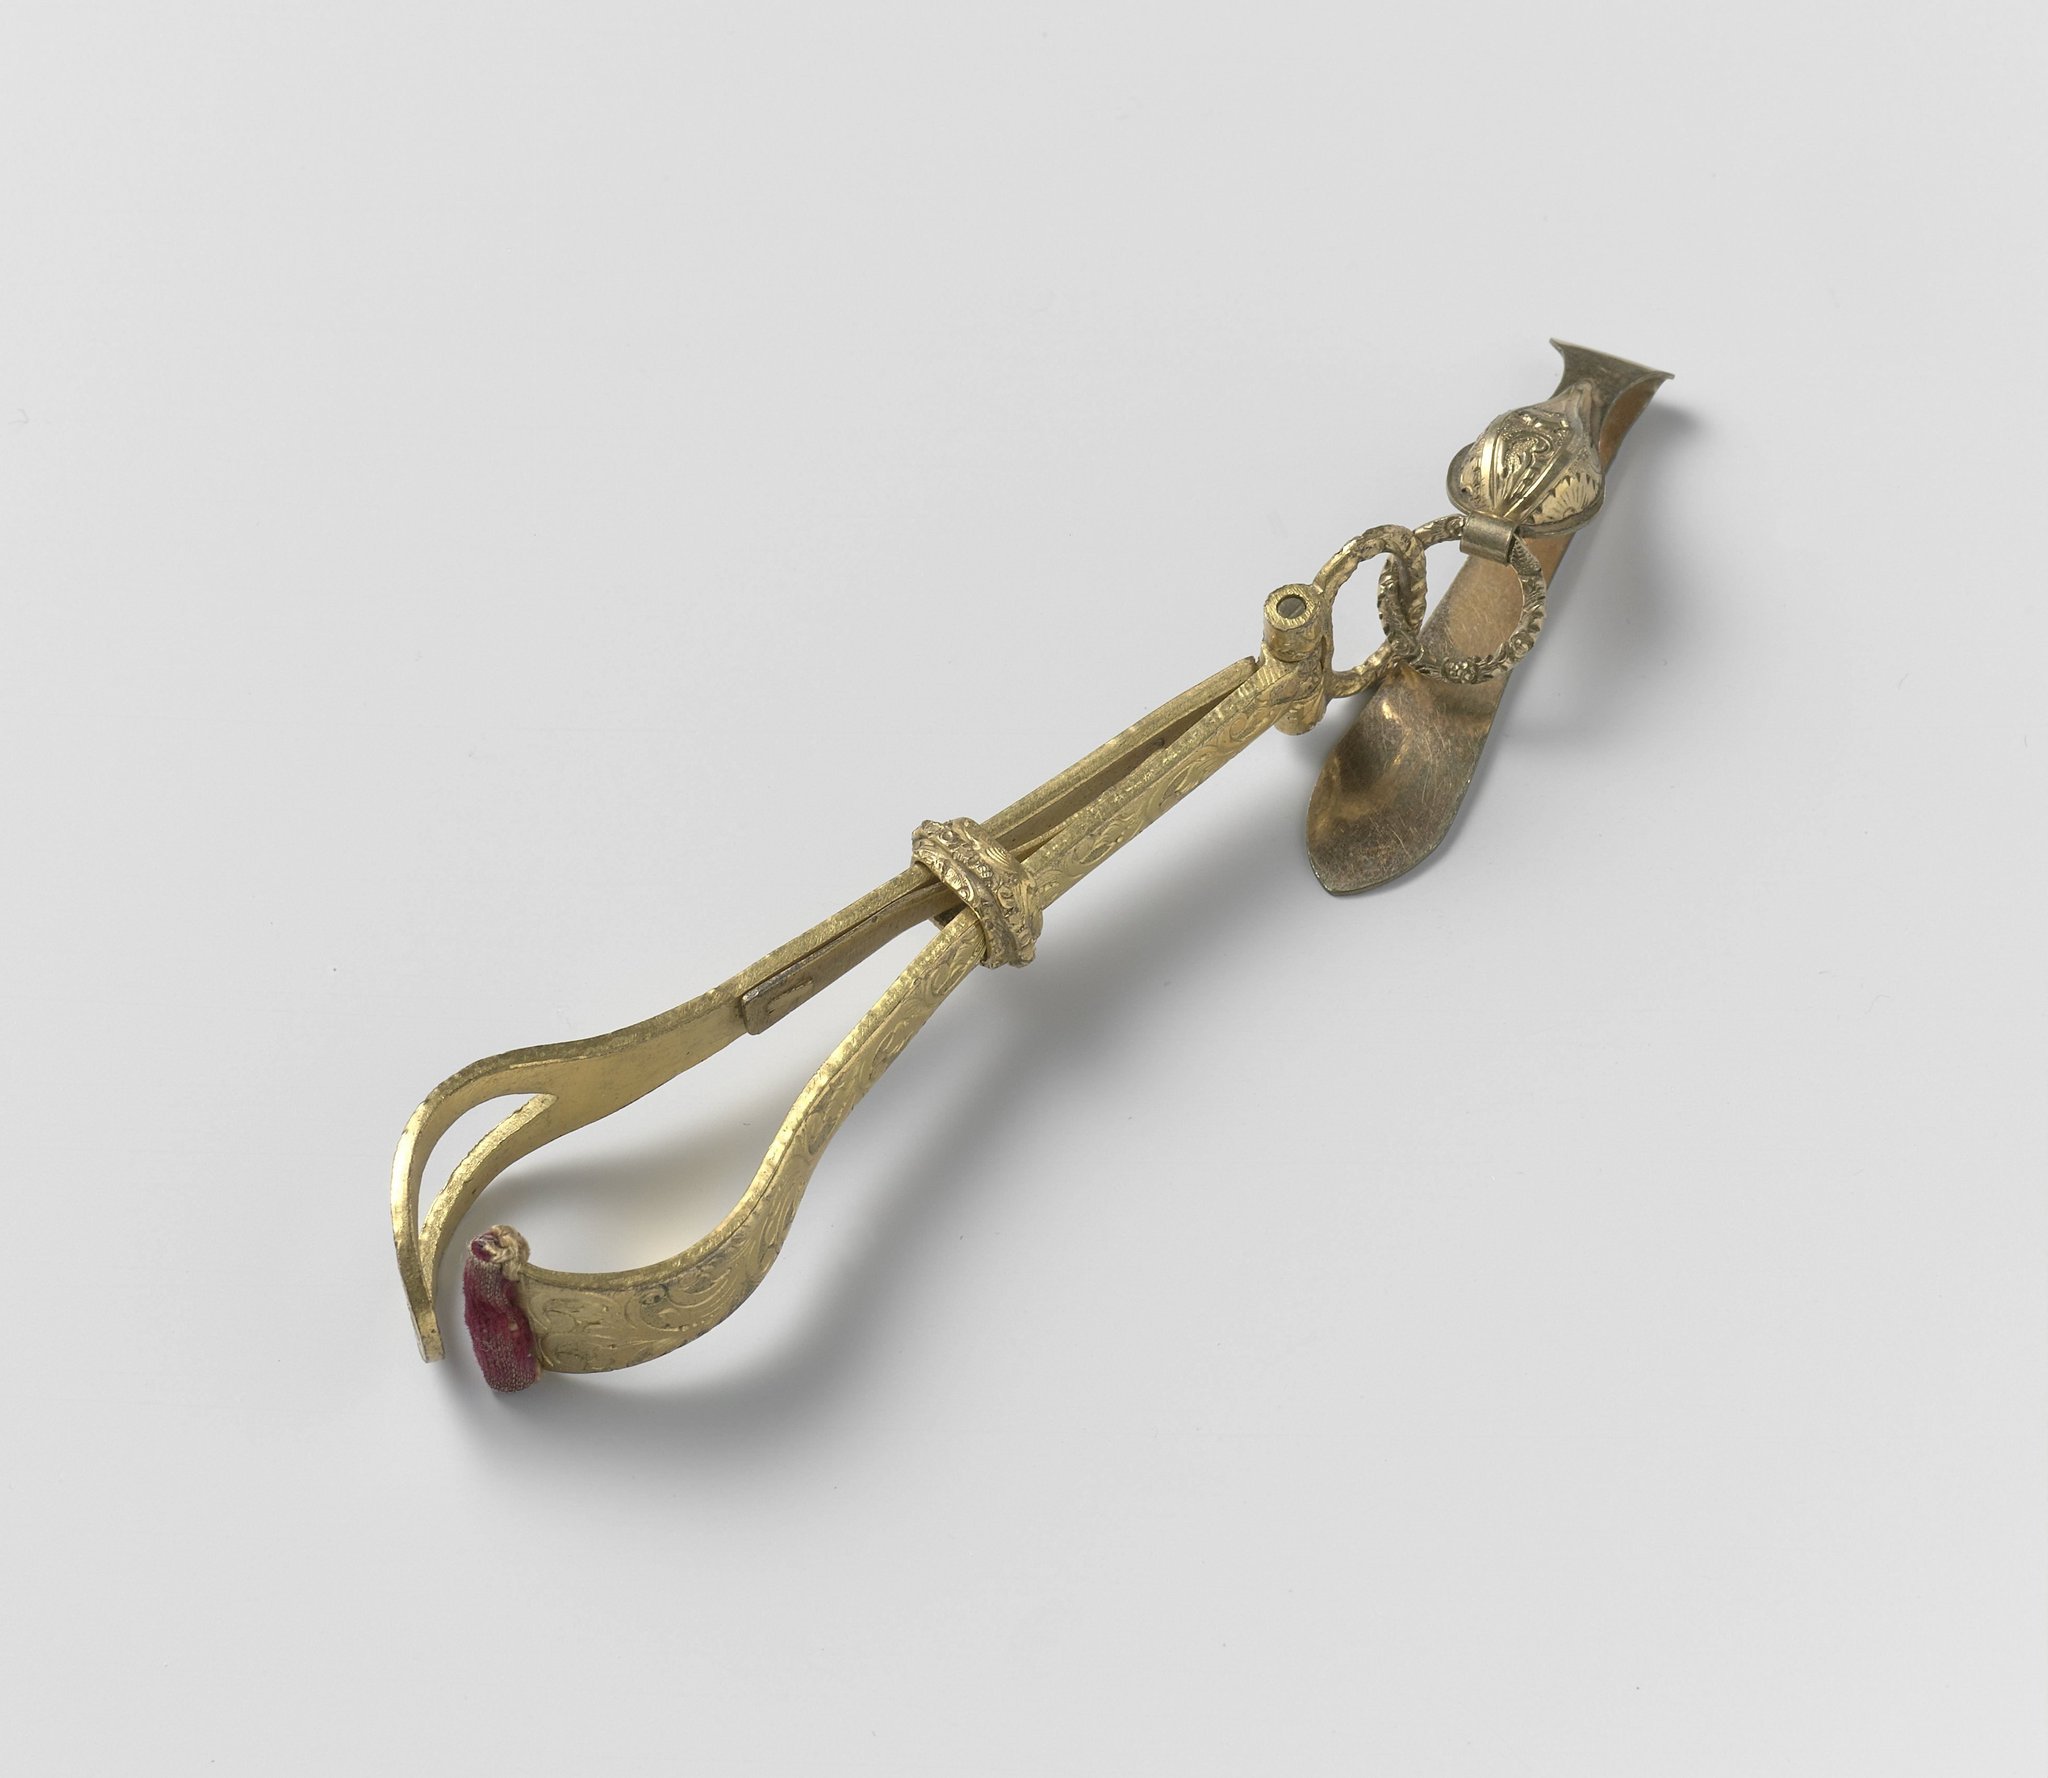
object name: rokophouder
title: Rokophouder van verguld koper met haak en klem, versierd met een motief van voluten en bloembladen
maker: Anonymous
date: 1860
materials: copper, velvet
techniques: forging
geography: united states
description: Rokophouder van verguld (?) koper. Een haak, die over de tailleband wordt geklemd, waaraan een groot rond oog waar met een ander ovaal oog de klem aan hangt. De klem wordt gesloten door een schuifje. Een van de uiteinden is voorzien van een beschermend stukje rood fluweel. Op de taillehaak een versiering van een druppelvormige uitstulping verdeeld in drie gelijke delen. De hele ophouder versierd met voluten en bloembladen. Binnen op de klem staat: Registered 1 jan. 1846.